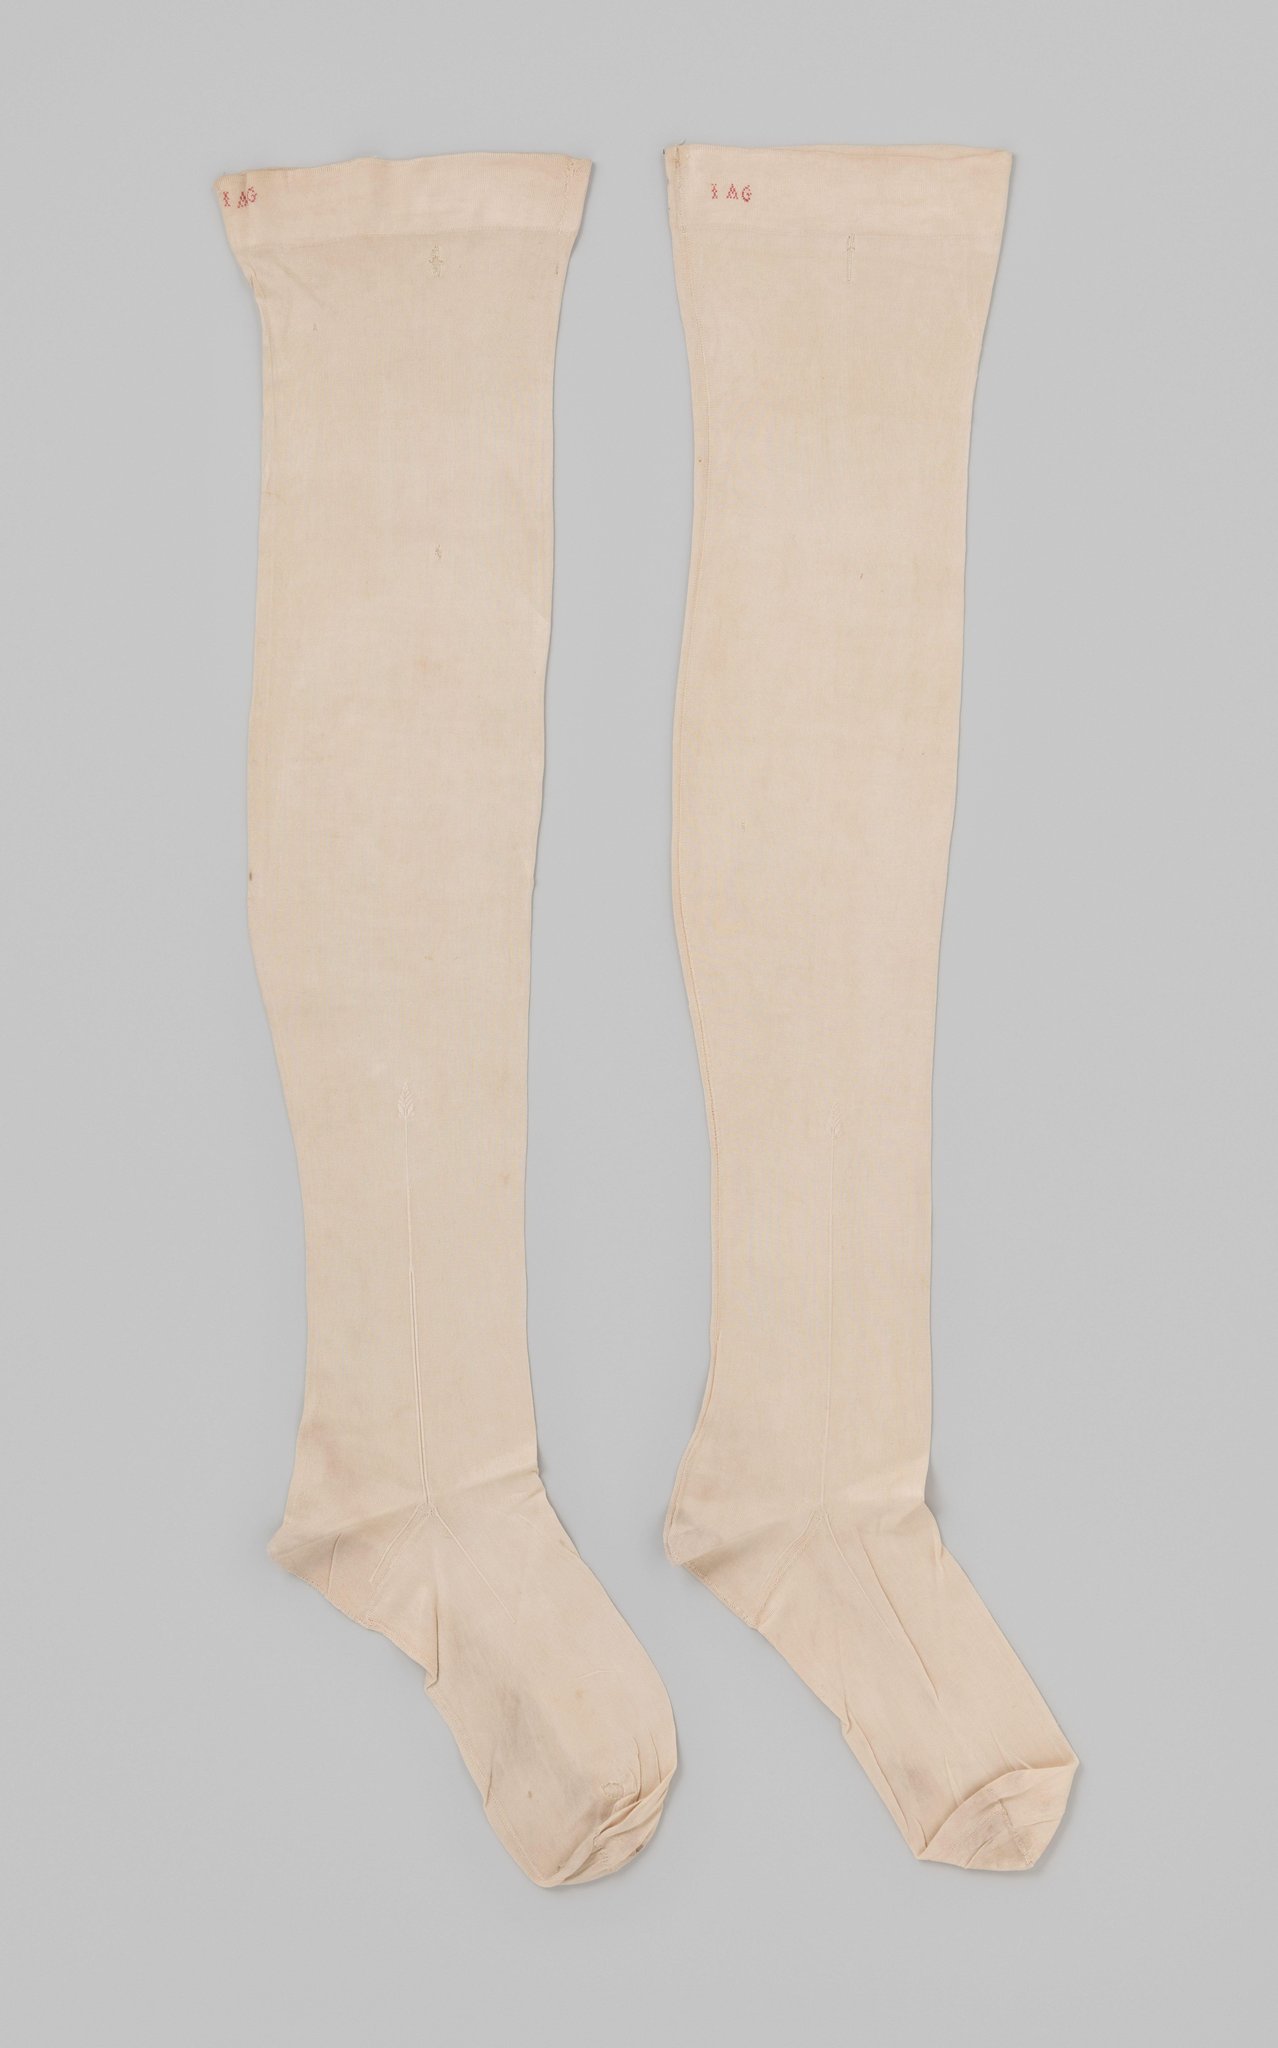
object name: stocking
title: Kous gebreid van effen witte zijde, met langs de klink een geborduurde lijn, uitlopend in een bladvorm, op de boord in rood in kruissteek 'I.A.G'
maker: Anonymous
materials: silk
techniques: cross stitching, embroidered, knitting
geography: netherlands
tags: vught, overveen, minister, staatsman, minister van financiën, izaak jean alexandre gogel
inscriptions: initials: ‘'IAG'’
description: Kous gebreid van effen witte zijde, met langs de klink een geborduurde lijn, uitlopend in een bladvorm, op de boord in rood in kruissteek 'I.A.G'